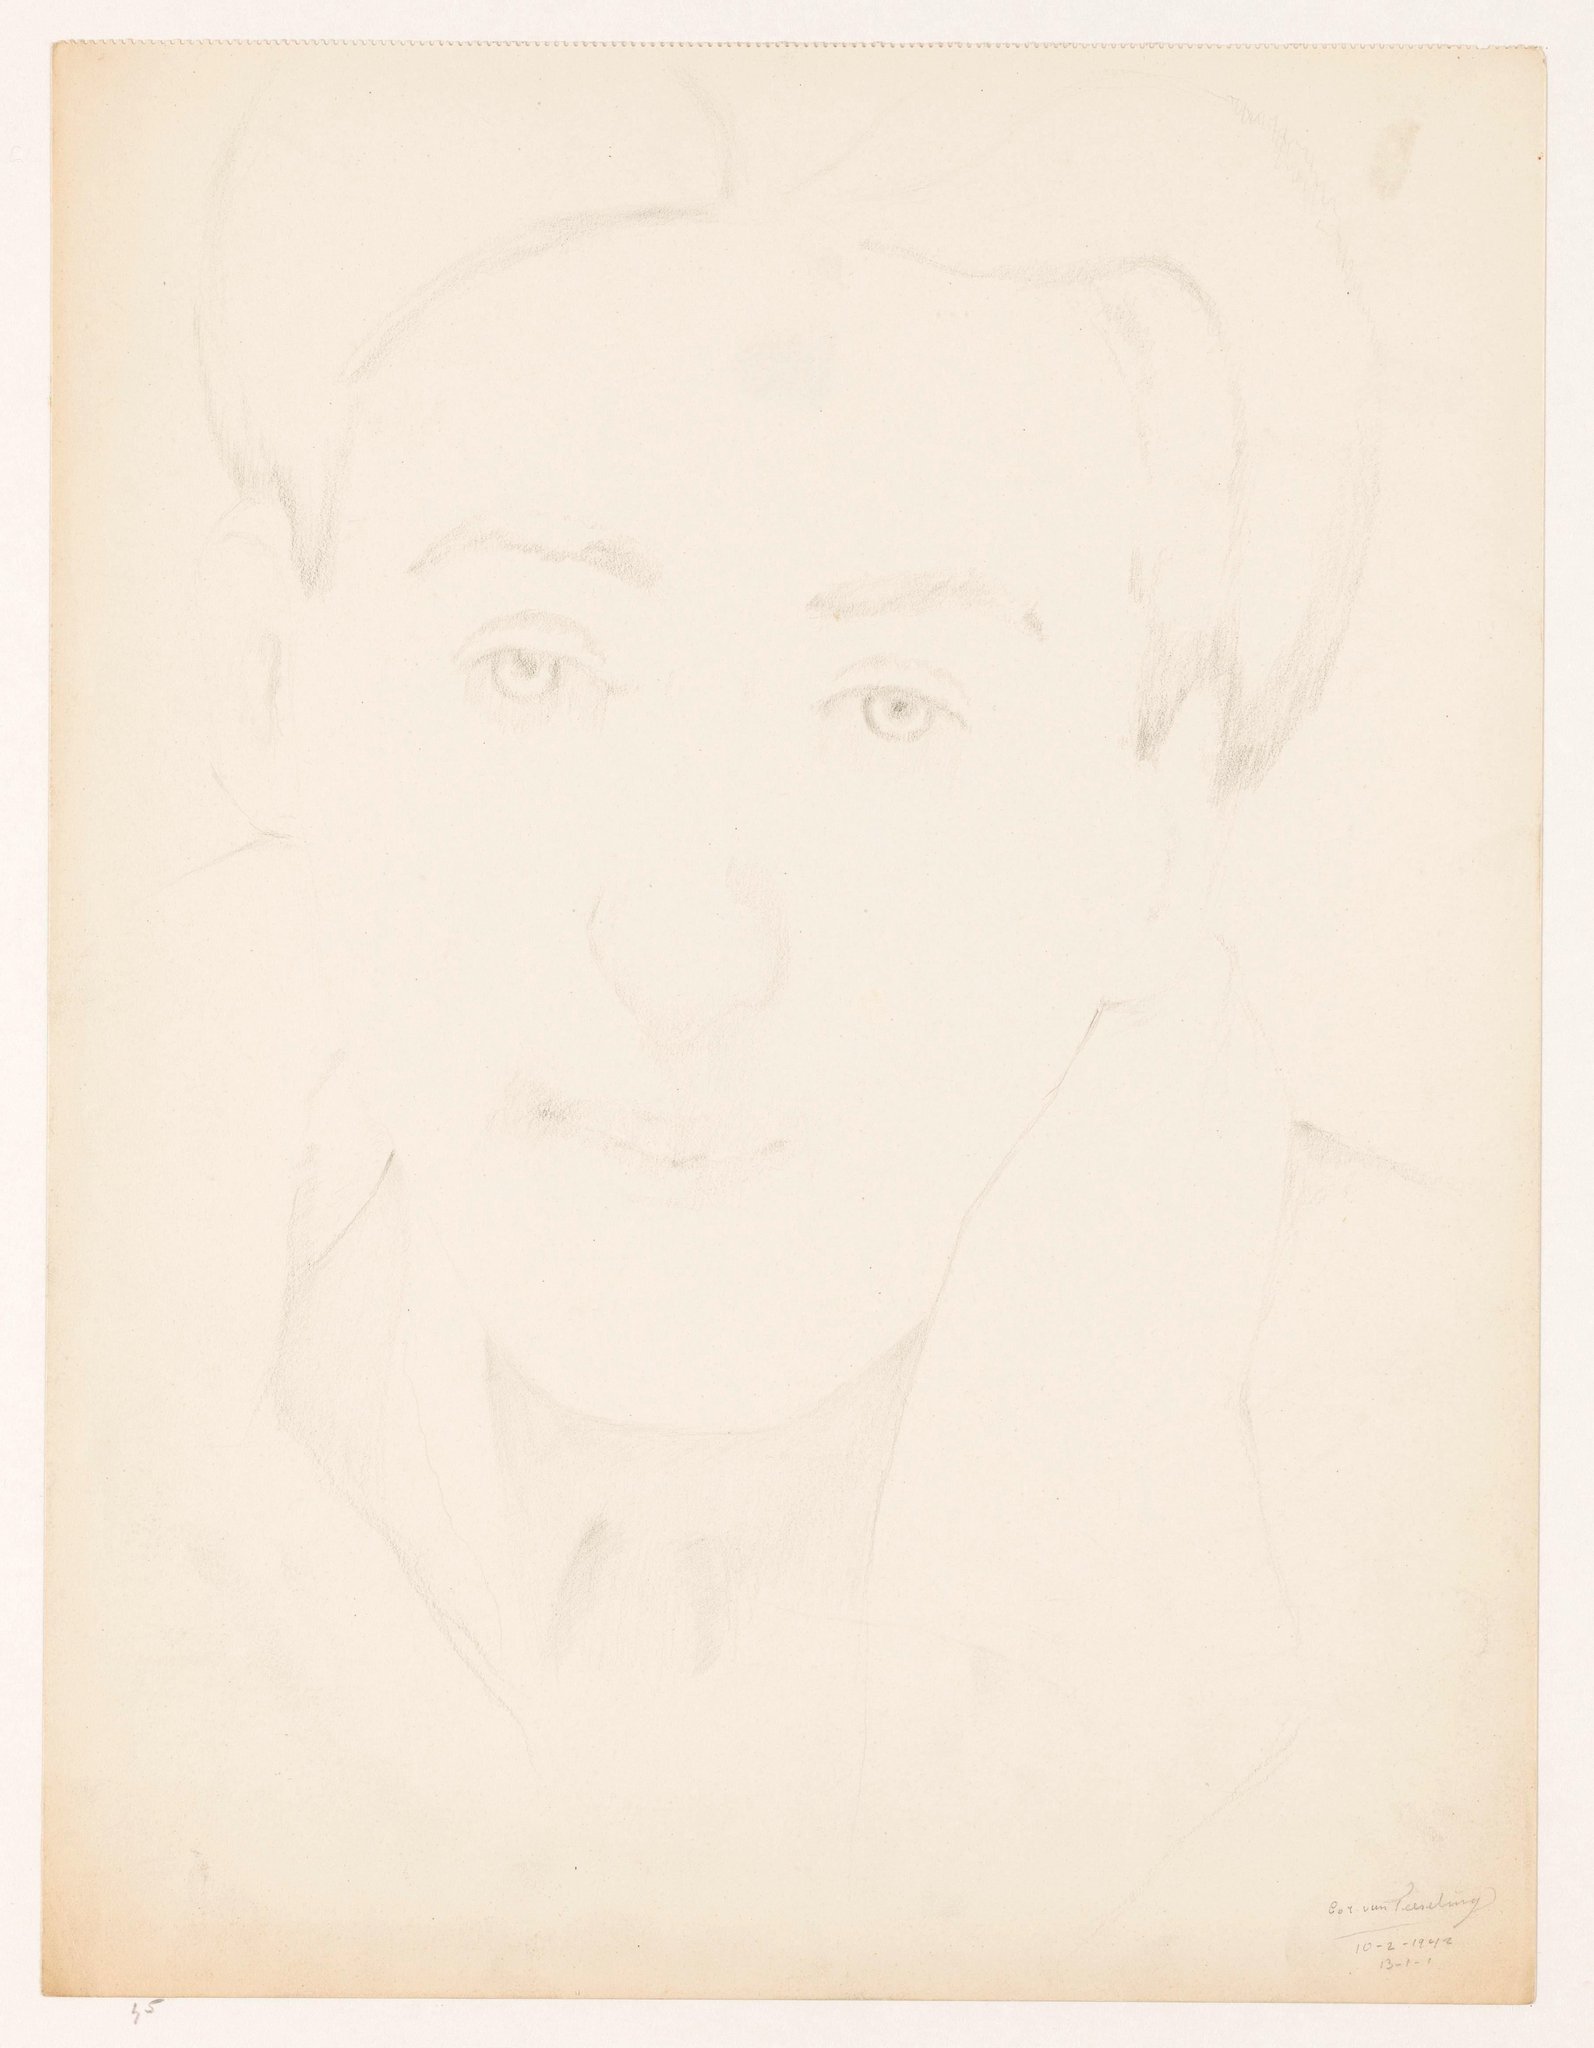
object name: drawing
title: Zelfportretten van Cor van Teeseling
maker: cor van teeseling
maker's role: draughtsman, sculptor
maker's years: 1915-1942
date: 1942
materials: paper, pencil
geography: weteringschans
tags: amsterdam, draughtsman, sculptor, cor van teeseling, historical persons, prisoner in cell or locked place, portrait, self-portrait of draughtsman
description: Onvoltooid getekend zelfportret van Cor van Teeseling en face: B-1-1, 10 februari.